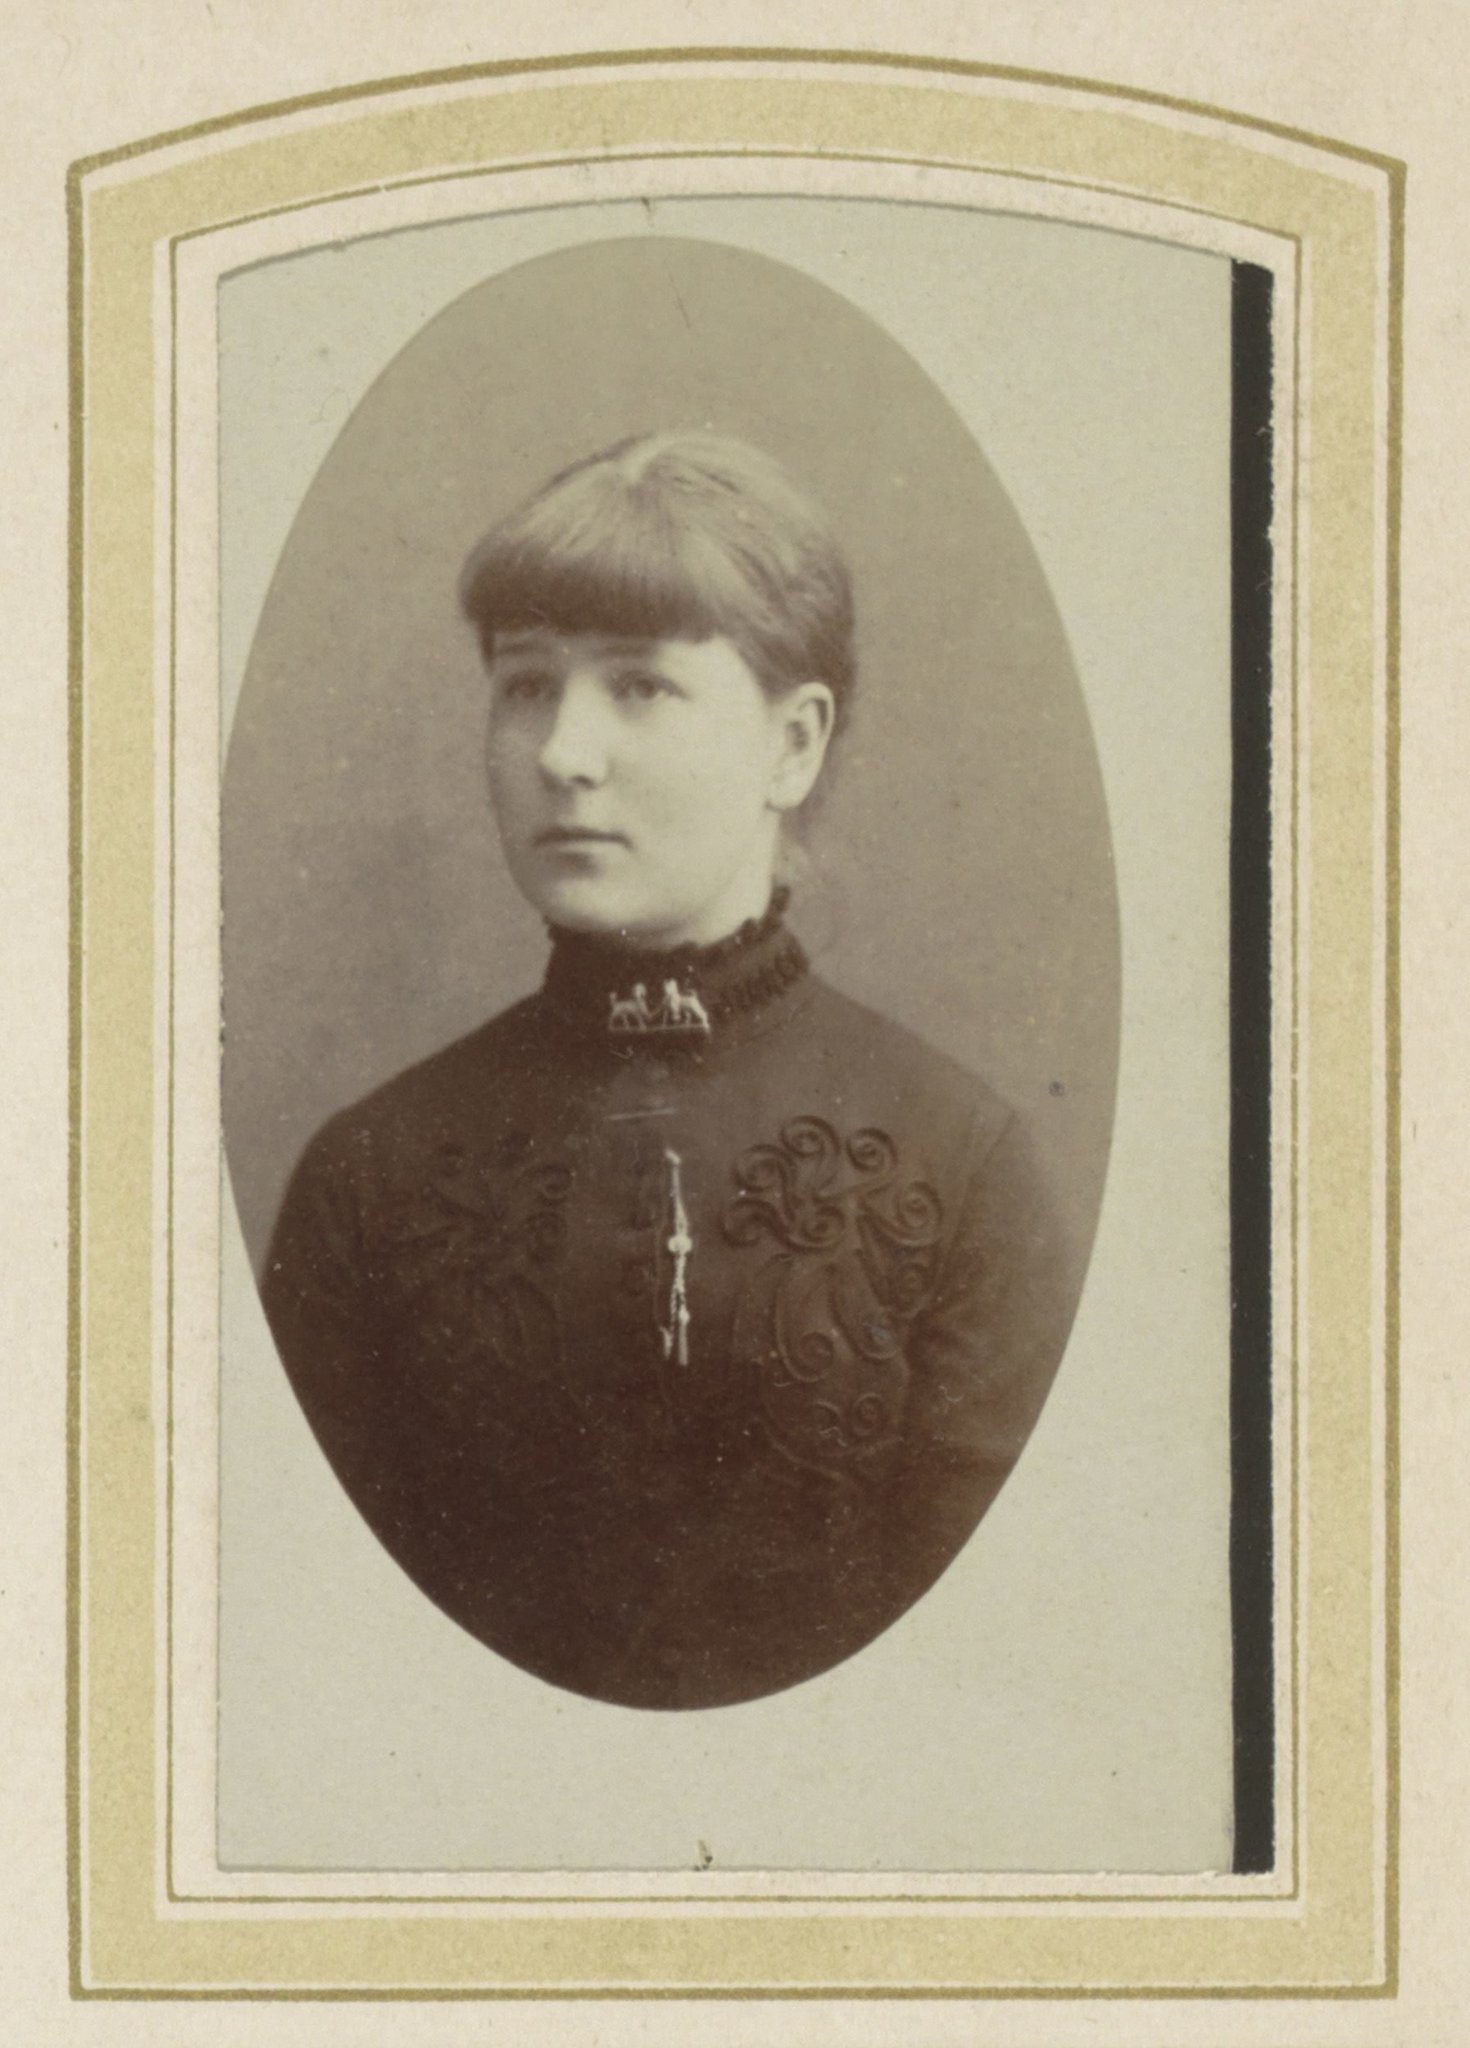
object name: carte de visite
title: Portret van een jongen vrouw met een broche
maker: franz reissig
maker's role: fotograaf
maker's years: 1852-1936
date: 1882-1910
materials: cardboard, paper, photographic support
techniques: albumen print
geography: breda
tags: historical persons, styles of hairdress - aa - ~ women, neck-gear ~ clothing, clothing for the upper part of the body, brooch, agraffe, clasp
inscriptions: address: ‘Breda Ginnekenstraat B 129.’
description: Onderdeel van Fotoalbum van een Nederlandse familie met 168 cartes-de-visite en kabinetfoto's.